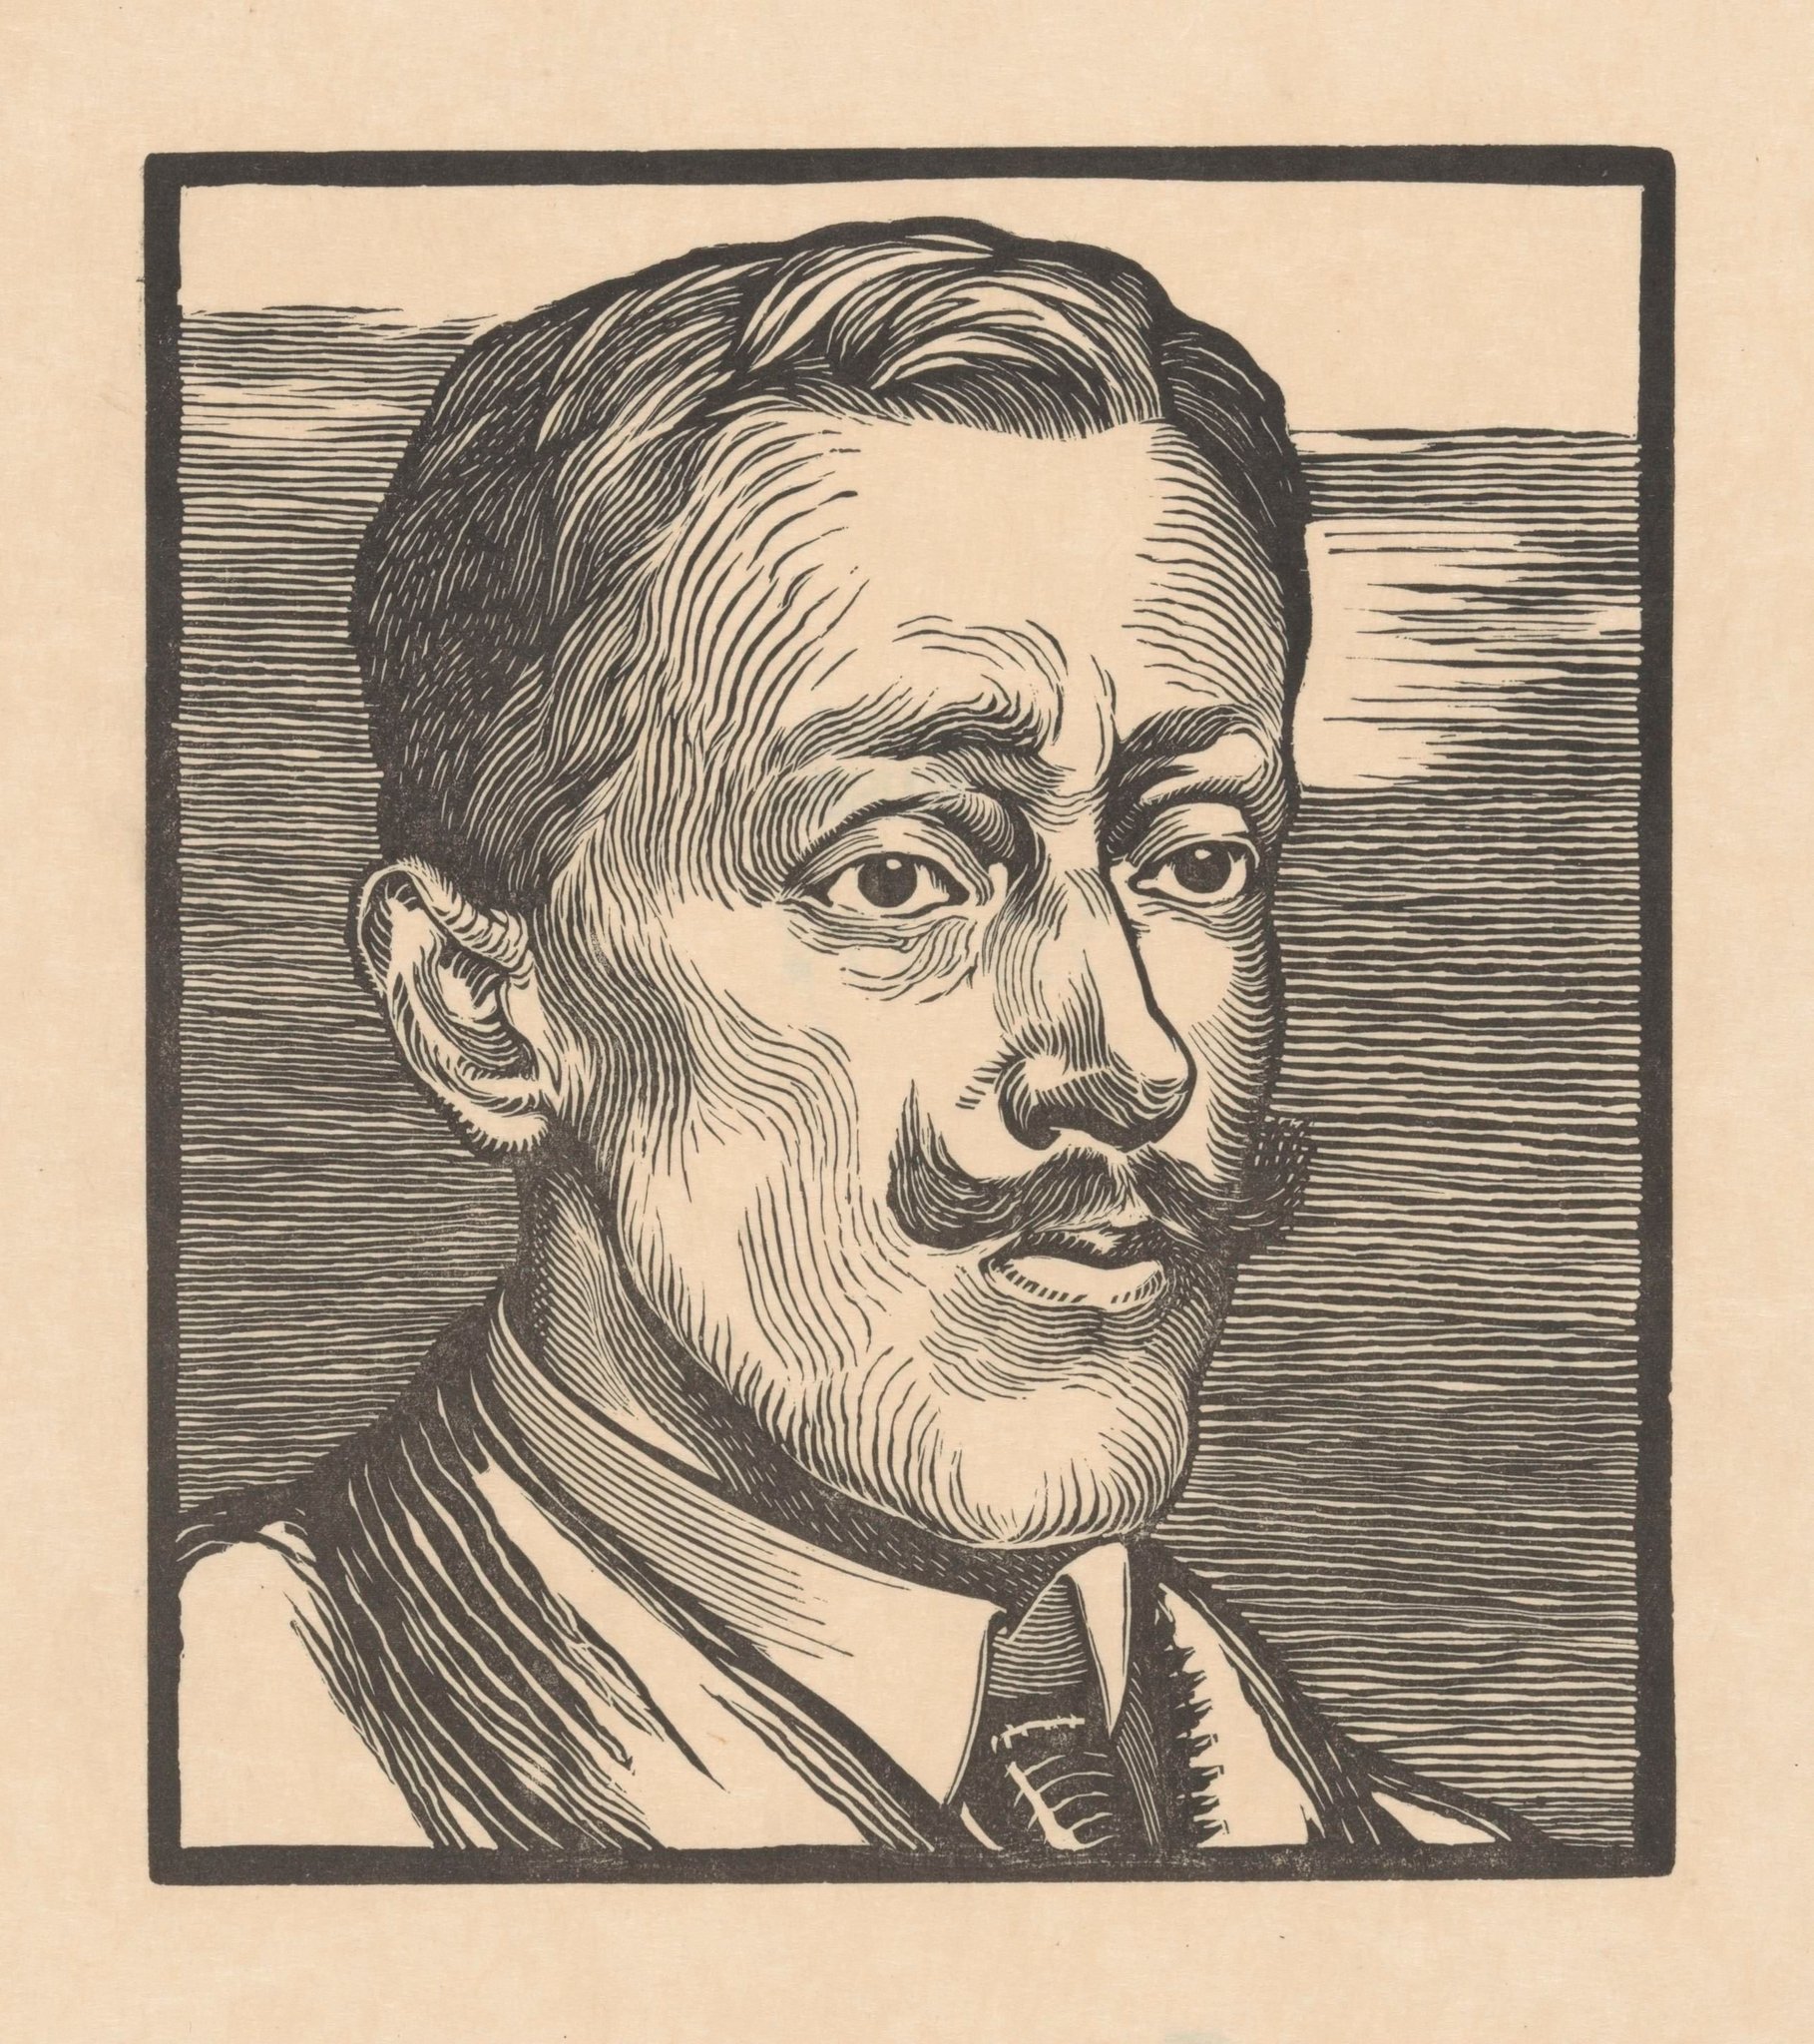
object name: print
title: Portret van François Gérard Waller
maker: johannes josephus aarts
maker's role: draughtsman, print maker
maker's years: 1871-1934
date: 1881-1934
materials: paper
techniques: woodcut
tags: moustache, art collector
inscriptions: collector's mark: Lugt 2760, collector's mark: Lugt 2166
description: Portret van museumbestuurder en verzamelaar François Gérard Waller.